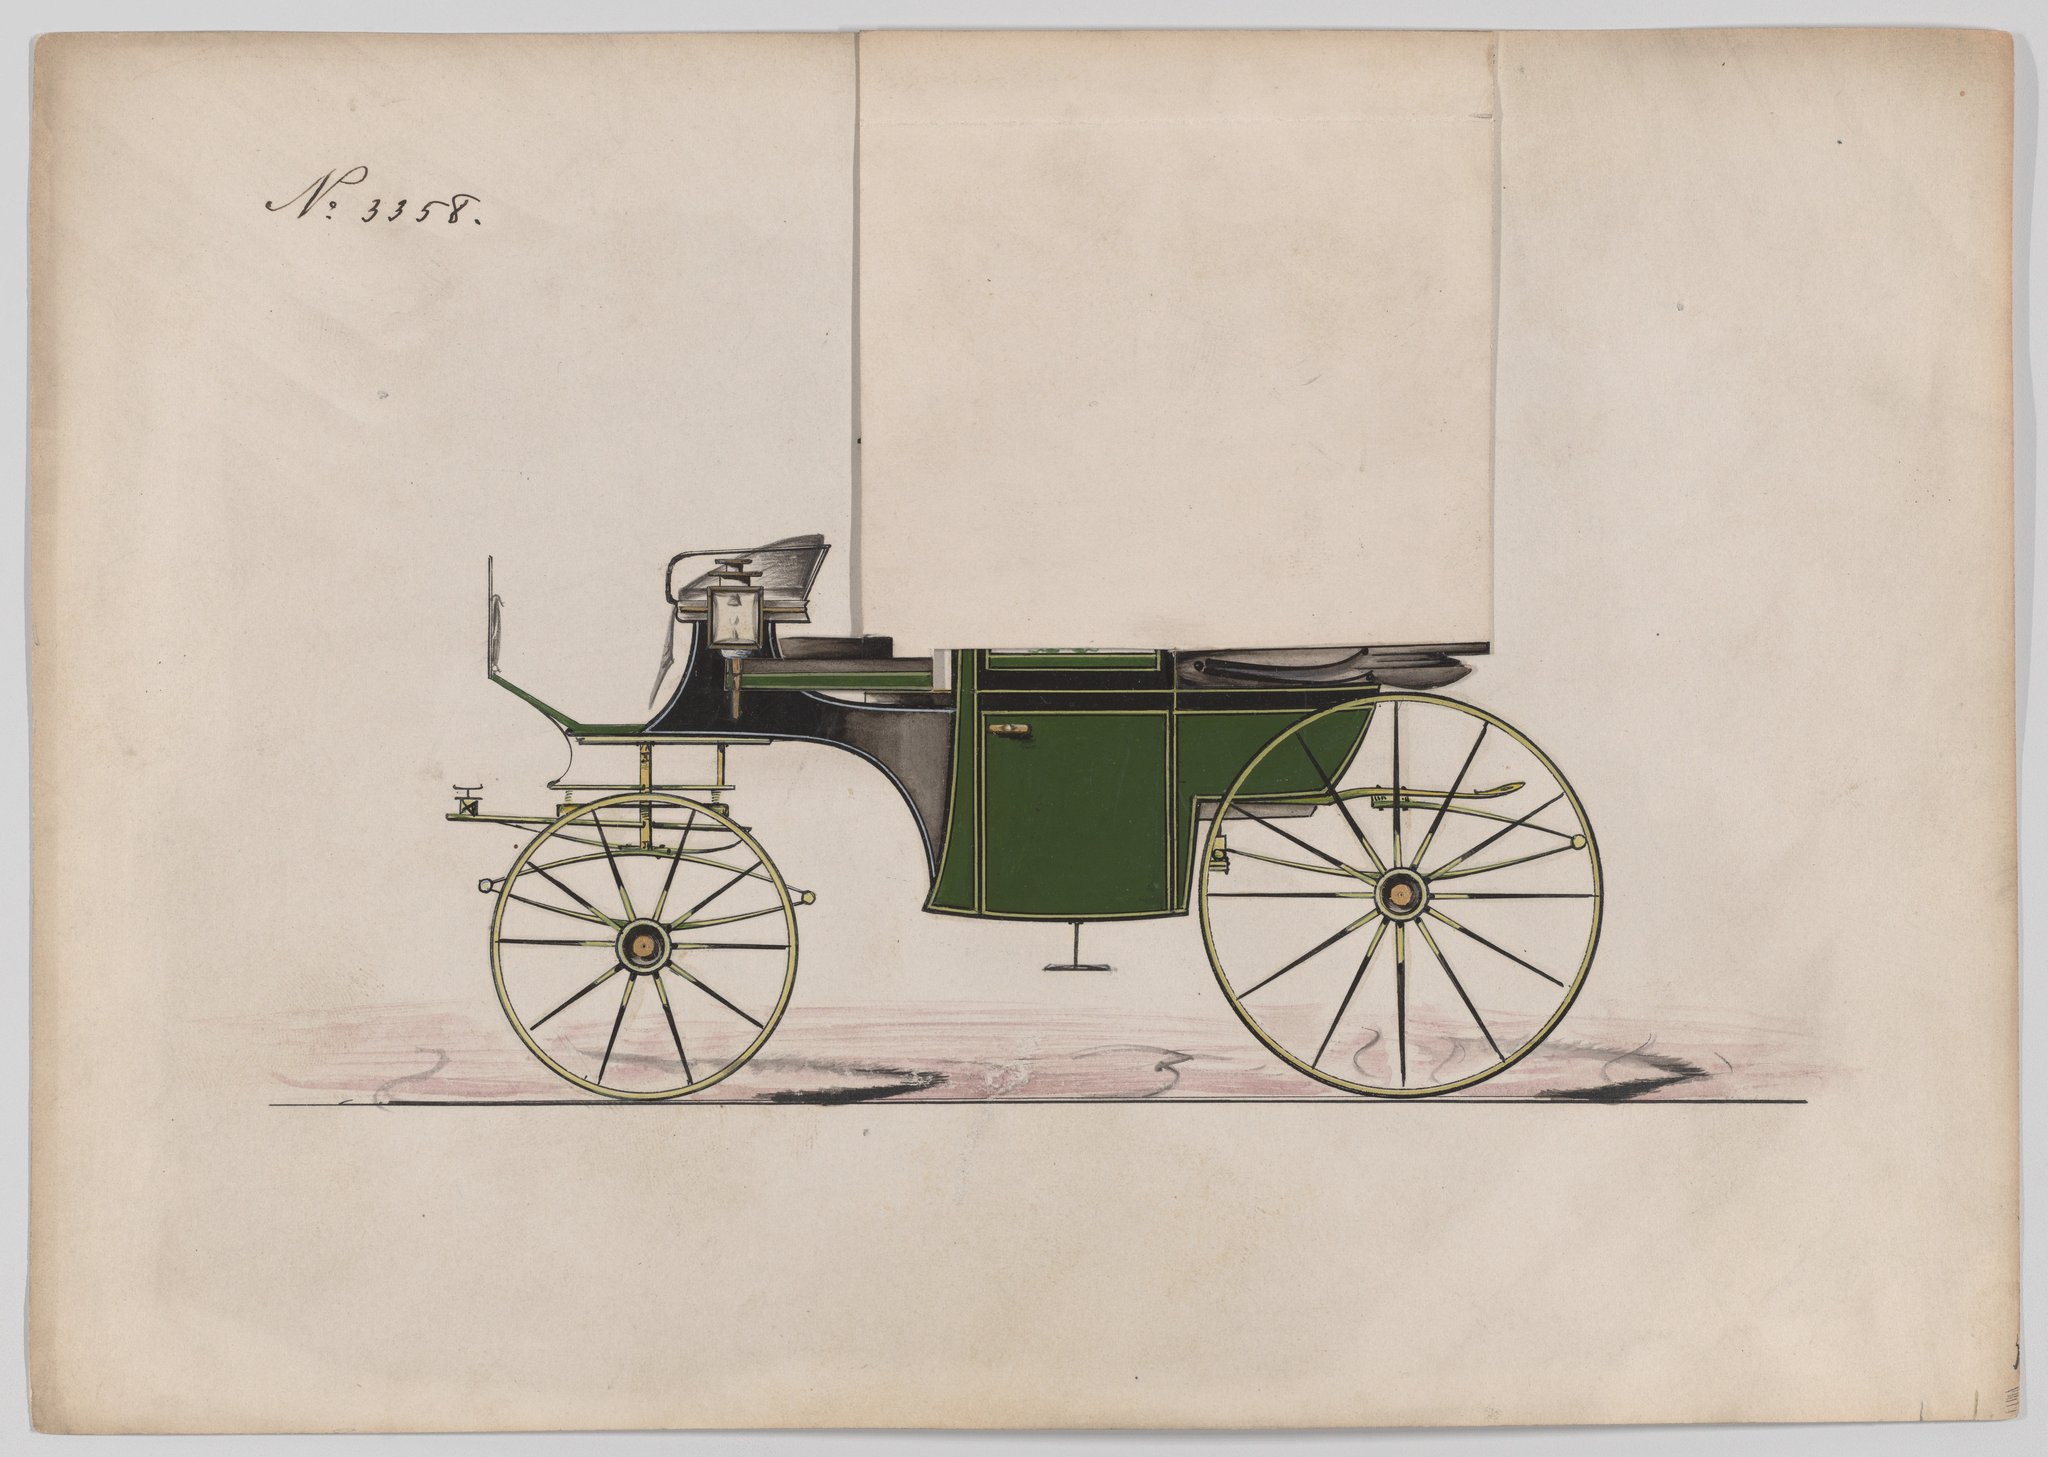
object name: drawing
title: Design for Landaulet, no. 3358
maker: brewster & co.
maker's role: manufacturer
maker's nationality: american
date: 1877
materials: gouache, gum arabic, ink, watercolor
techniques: pen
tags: carriages